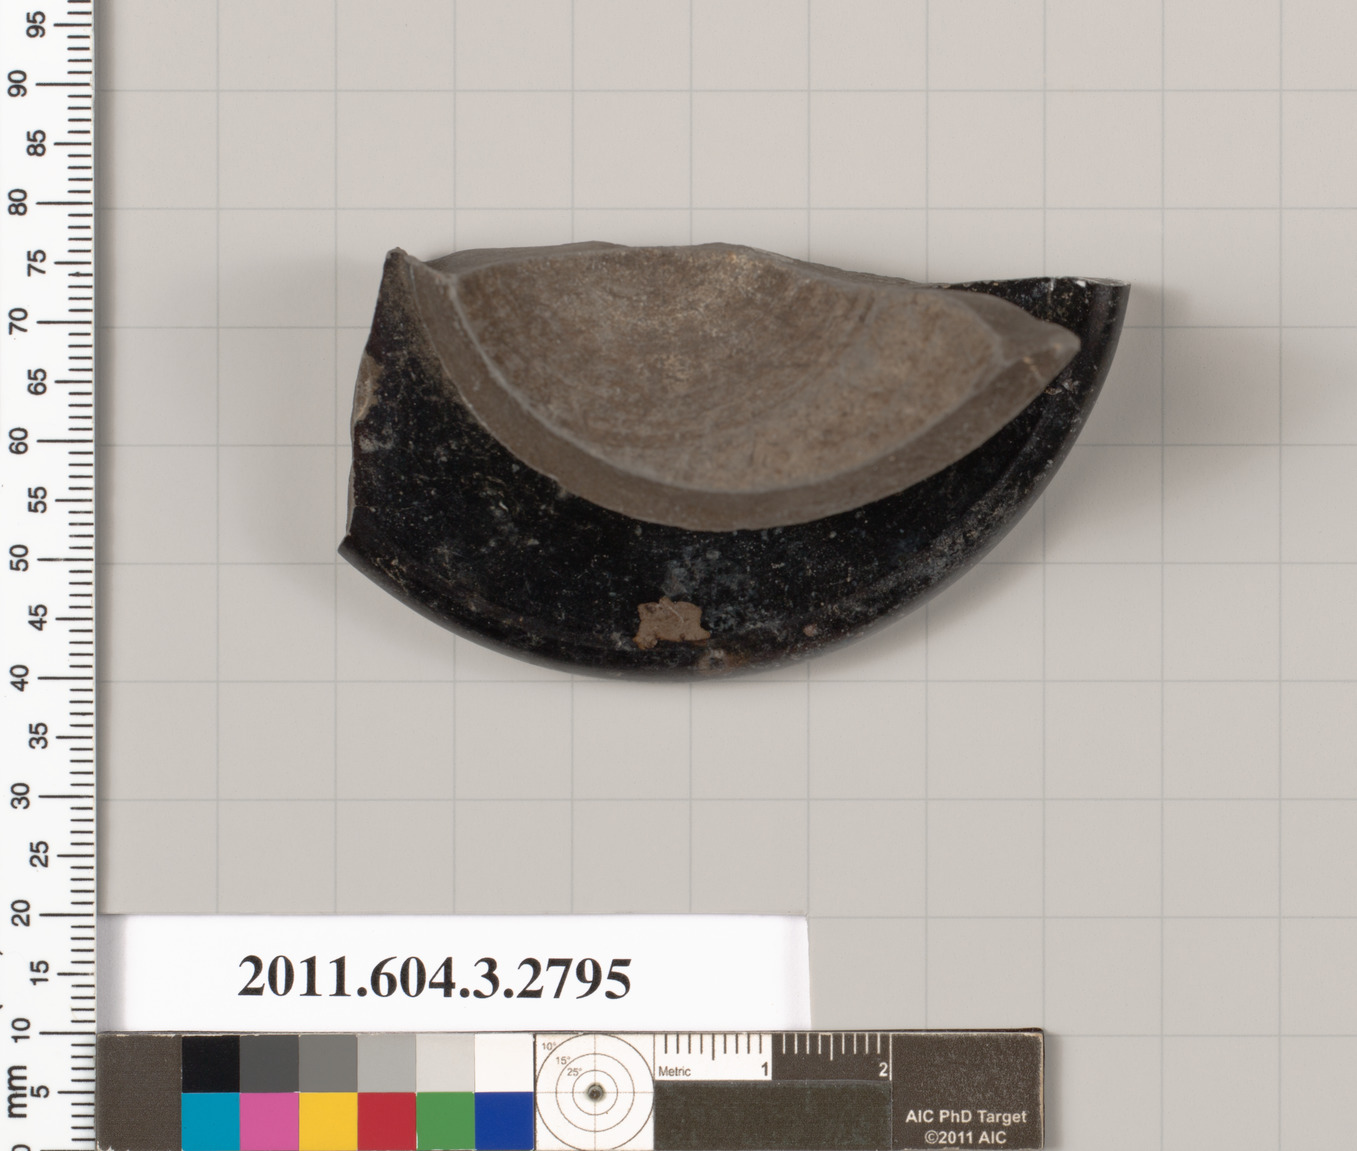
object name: oinochoe or olpe fragment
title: Terracotta fragment of an oinochoe (jug) or olpe (jug)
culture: greek, attic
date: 600-401 BCE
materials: terracotta